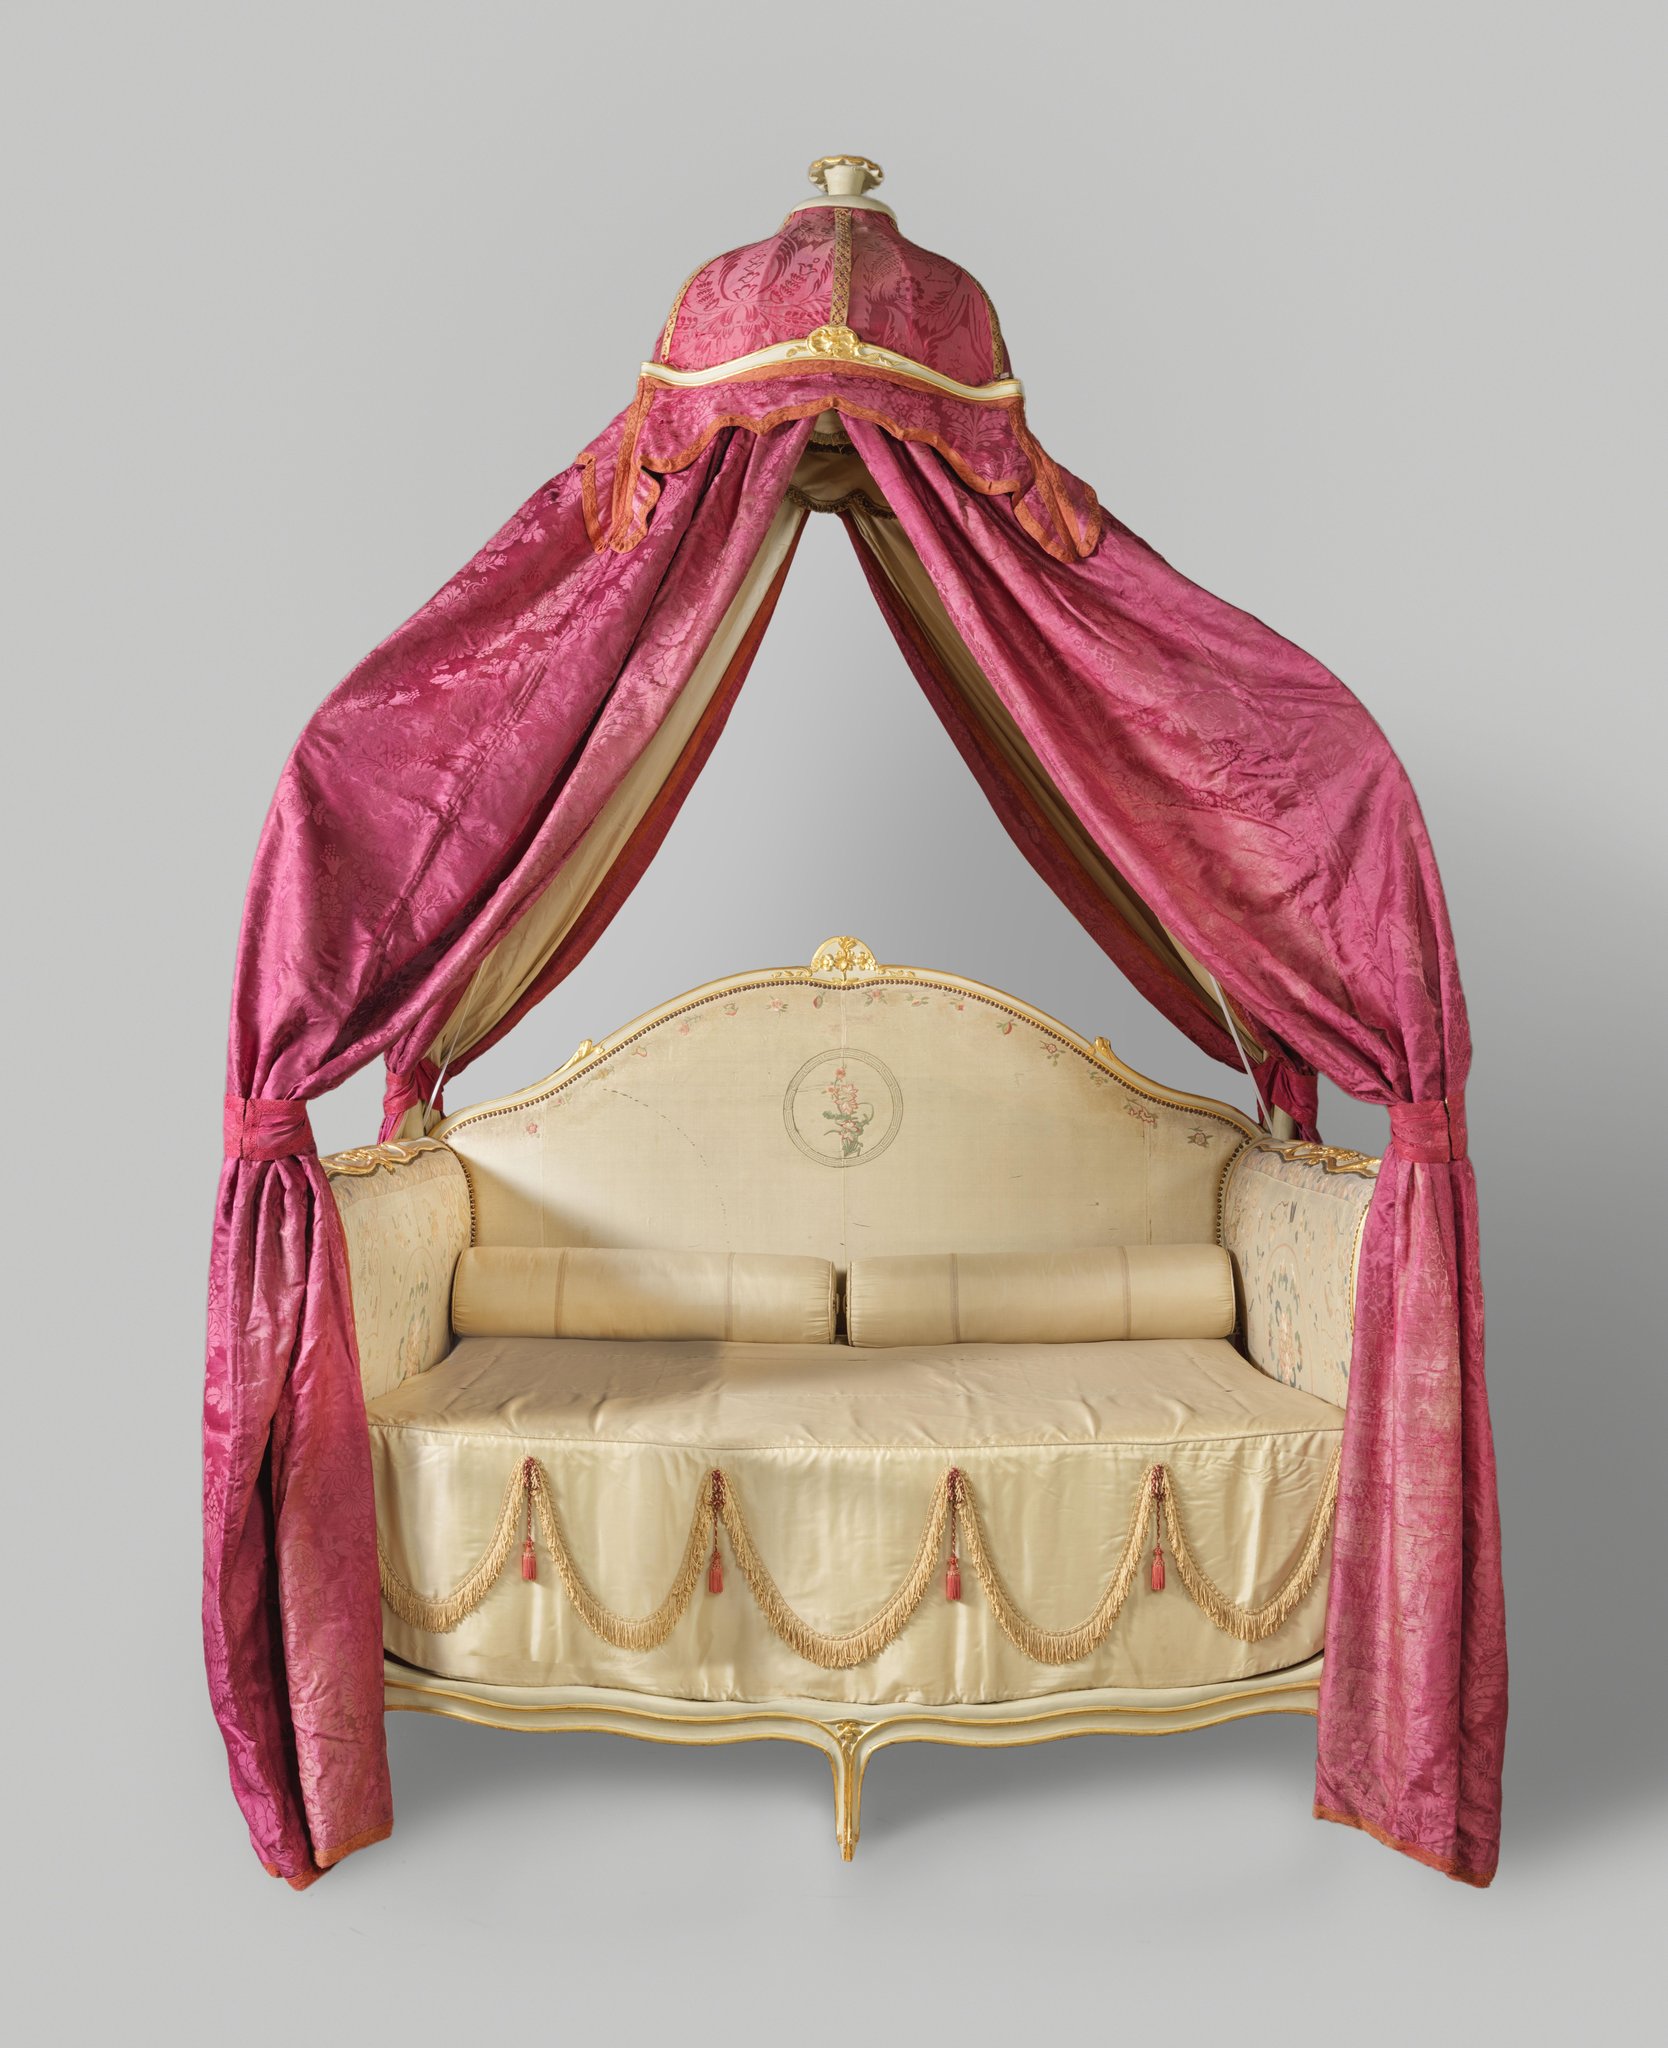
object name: canopy bed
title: Hemelbed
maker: Anonymous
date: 1740-1760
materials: textile, wood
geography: france